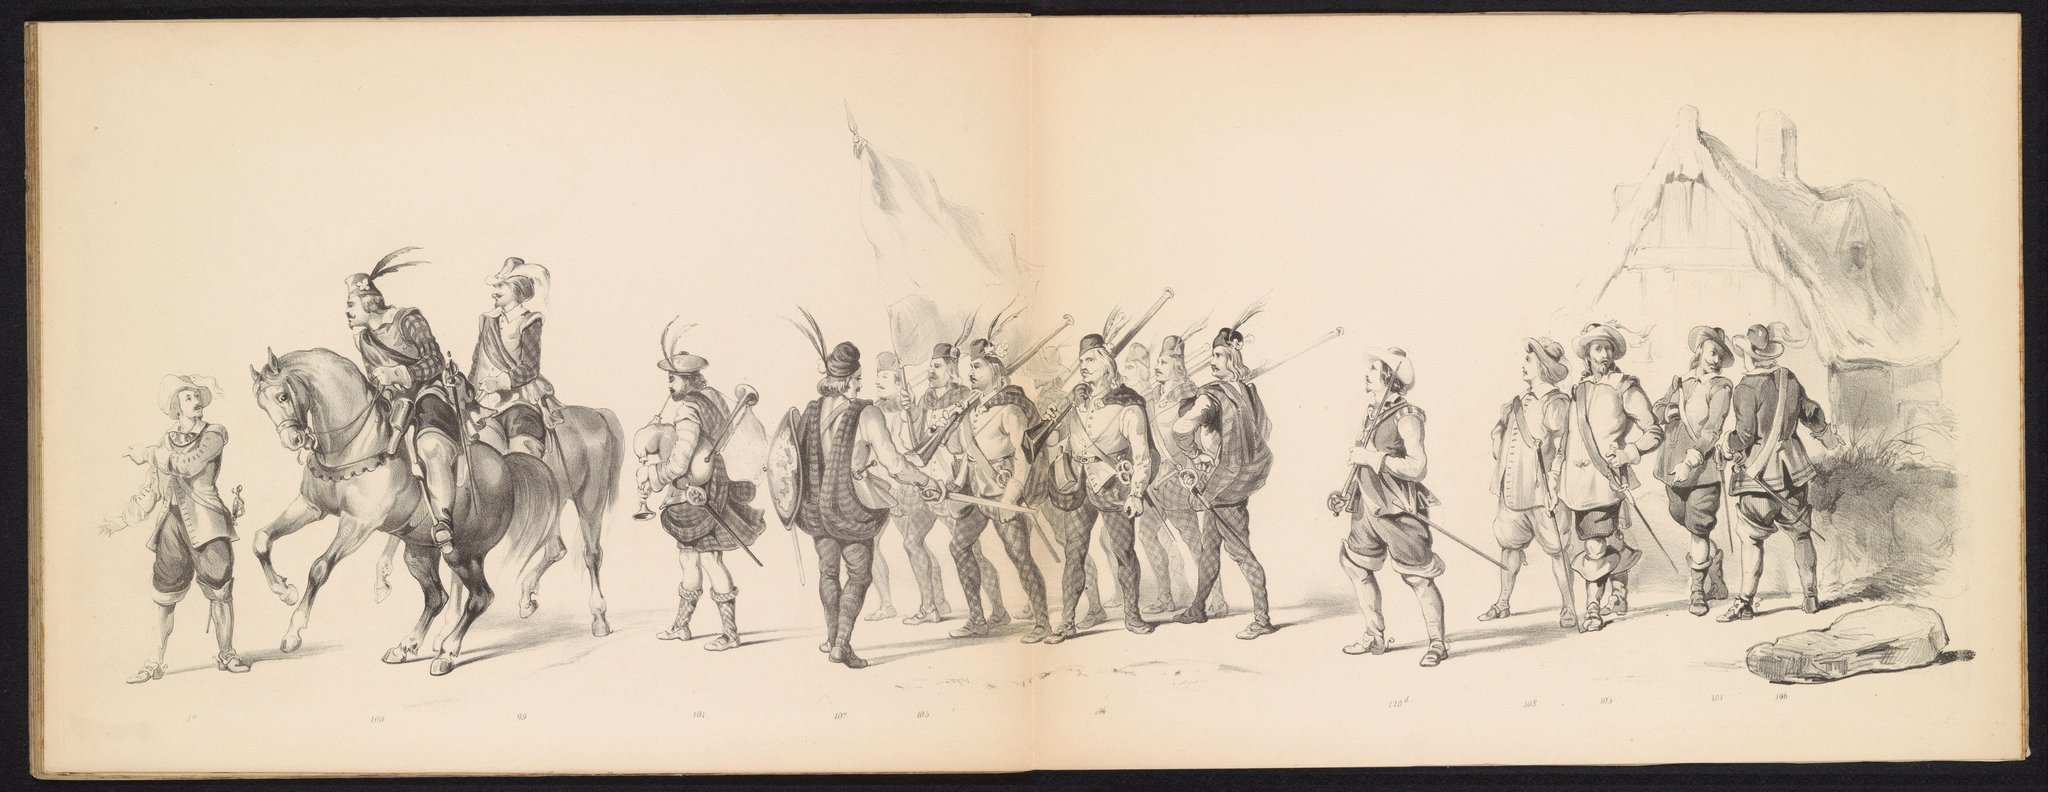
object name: text sheet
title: Maskerade van de Leidse studenten, 1850 (plaat 11)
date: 1850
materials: paper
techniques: lithograph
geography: the hague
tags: delft, the hague, frederick henry (prince of orange), students' pageant, costumes used in pageants, leiden, den bosch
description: Historische gekostumeerde optocht van de studenten van de Leidse Hogeschool op 11 juni 1850. De optocht verbeeldt de intocht van Frederik Hendrik te Den Bosch in 1629. Elfde plaat met de groepen genummerd 99-108. Onderdeel van de serie van dertien aanelkaar geplakte bladen.